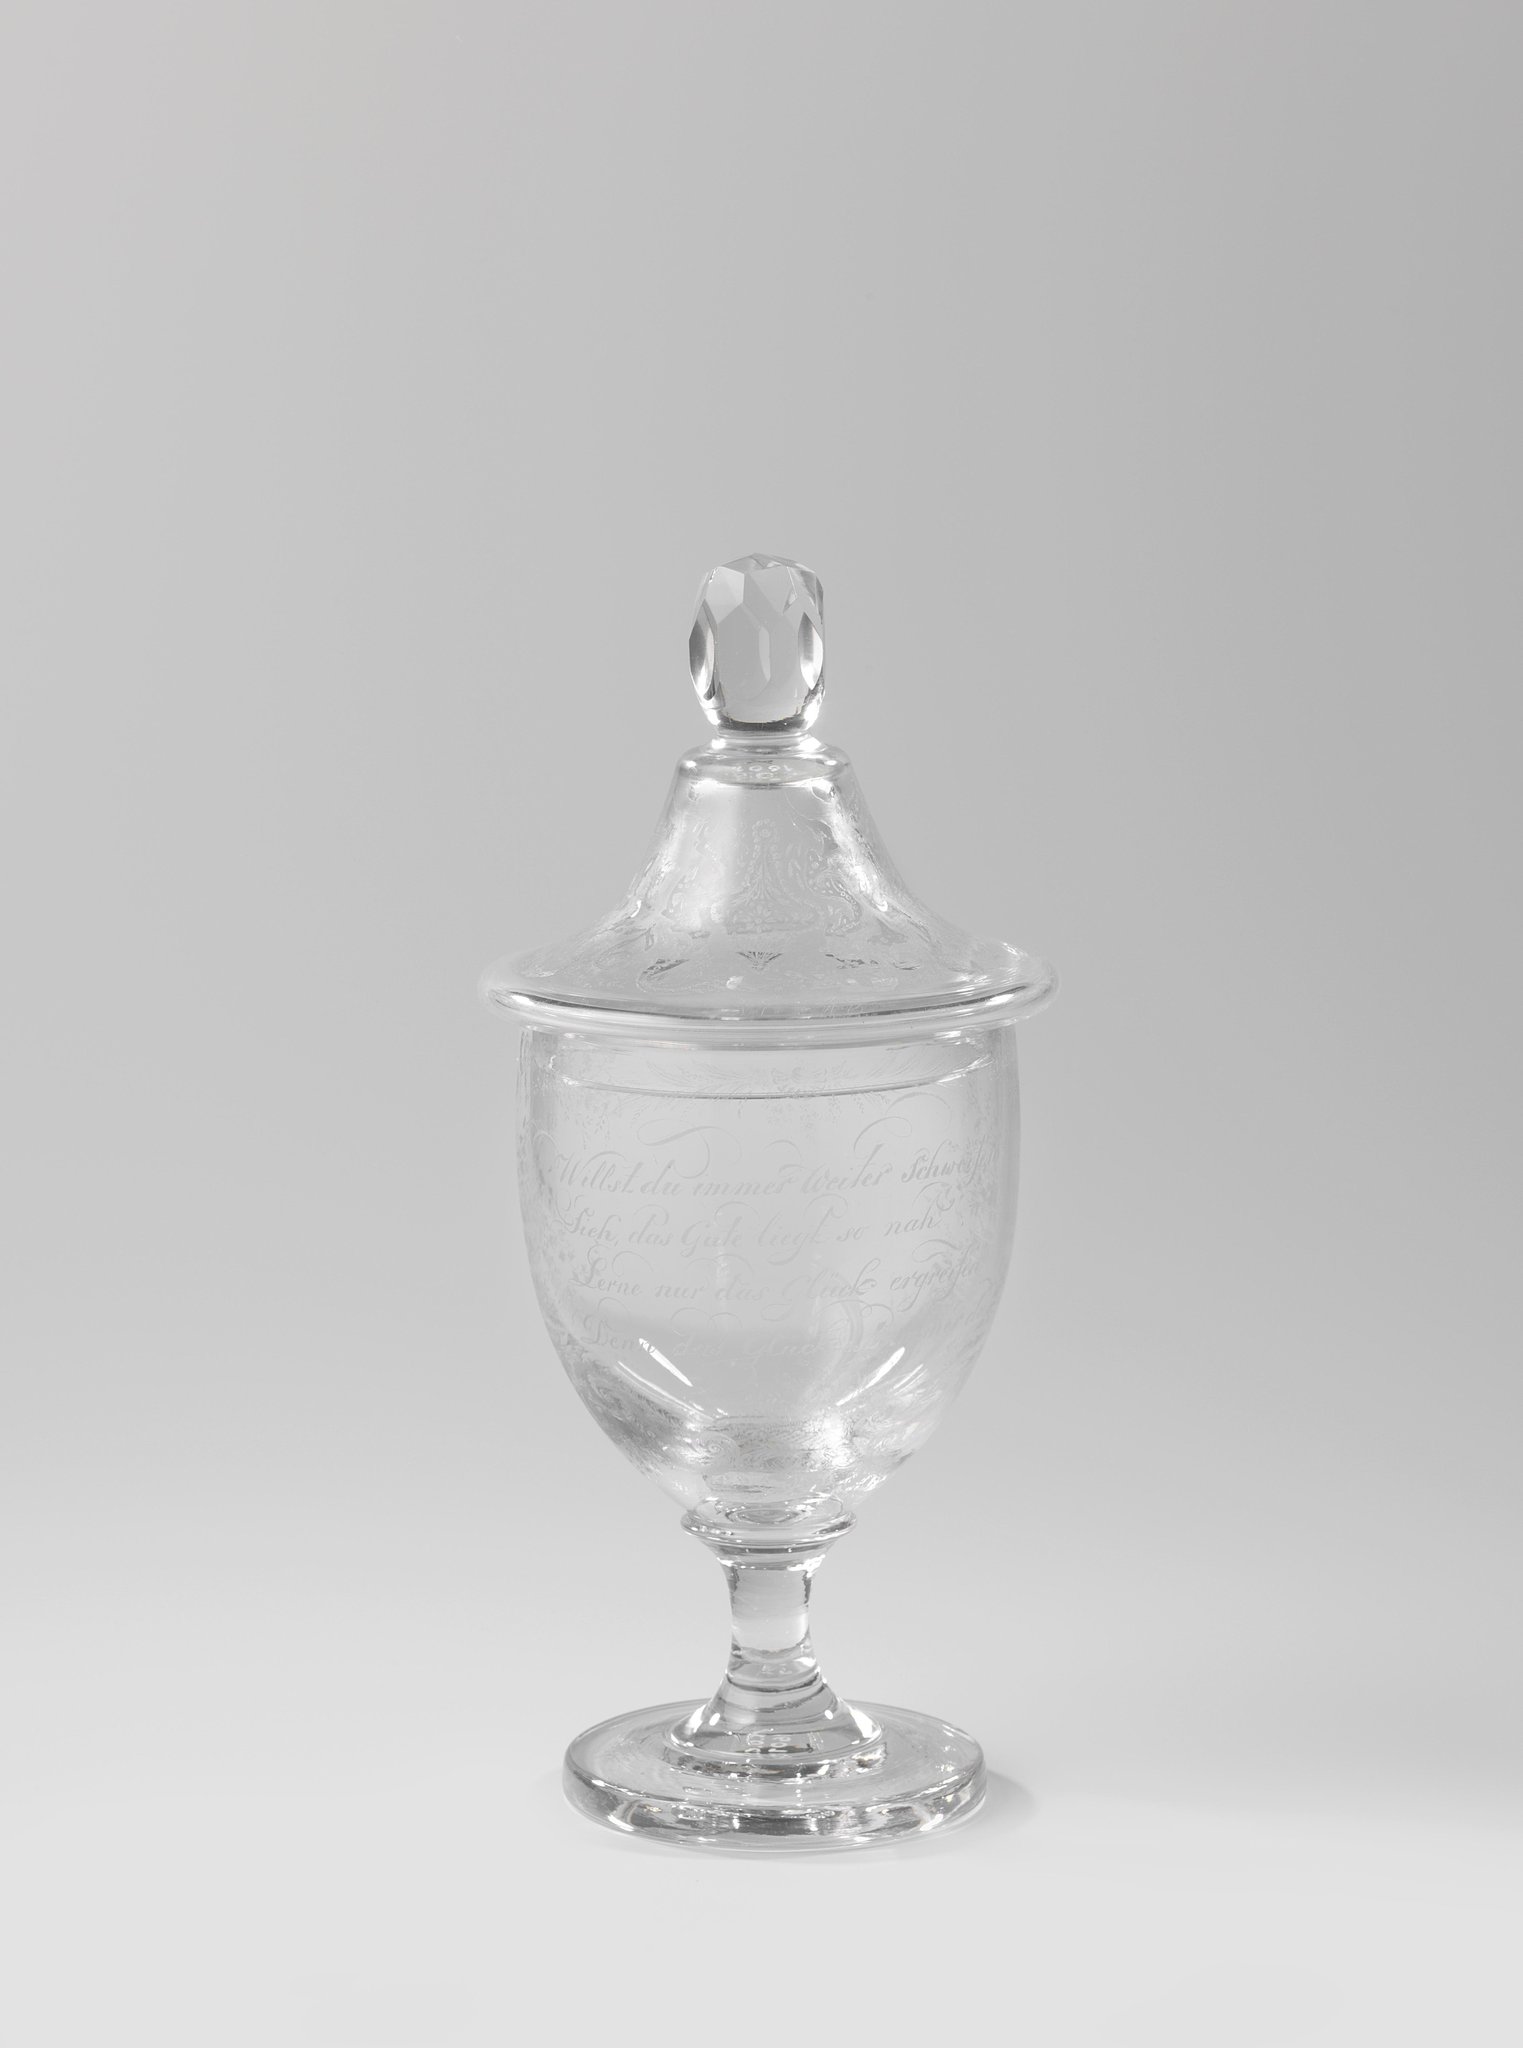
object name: lid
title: Bokaal met deksel, met een gedicht van Goethe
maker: daniël henriques de castro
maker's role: glasgraveur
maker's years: 1806-1863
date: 1860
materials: glass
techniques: diamond point engraving, etching, glassblowing, grinding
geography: amsterdam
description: Poem after Goethe 'Erinnerungen'. Diamond-point engraving and etching by Daniel H. de Castro (1808 - 1863), 1860. On loan from the Koninklijk Oudheidkundig Genootschap.